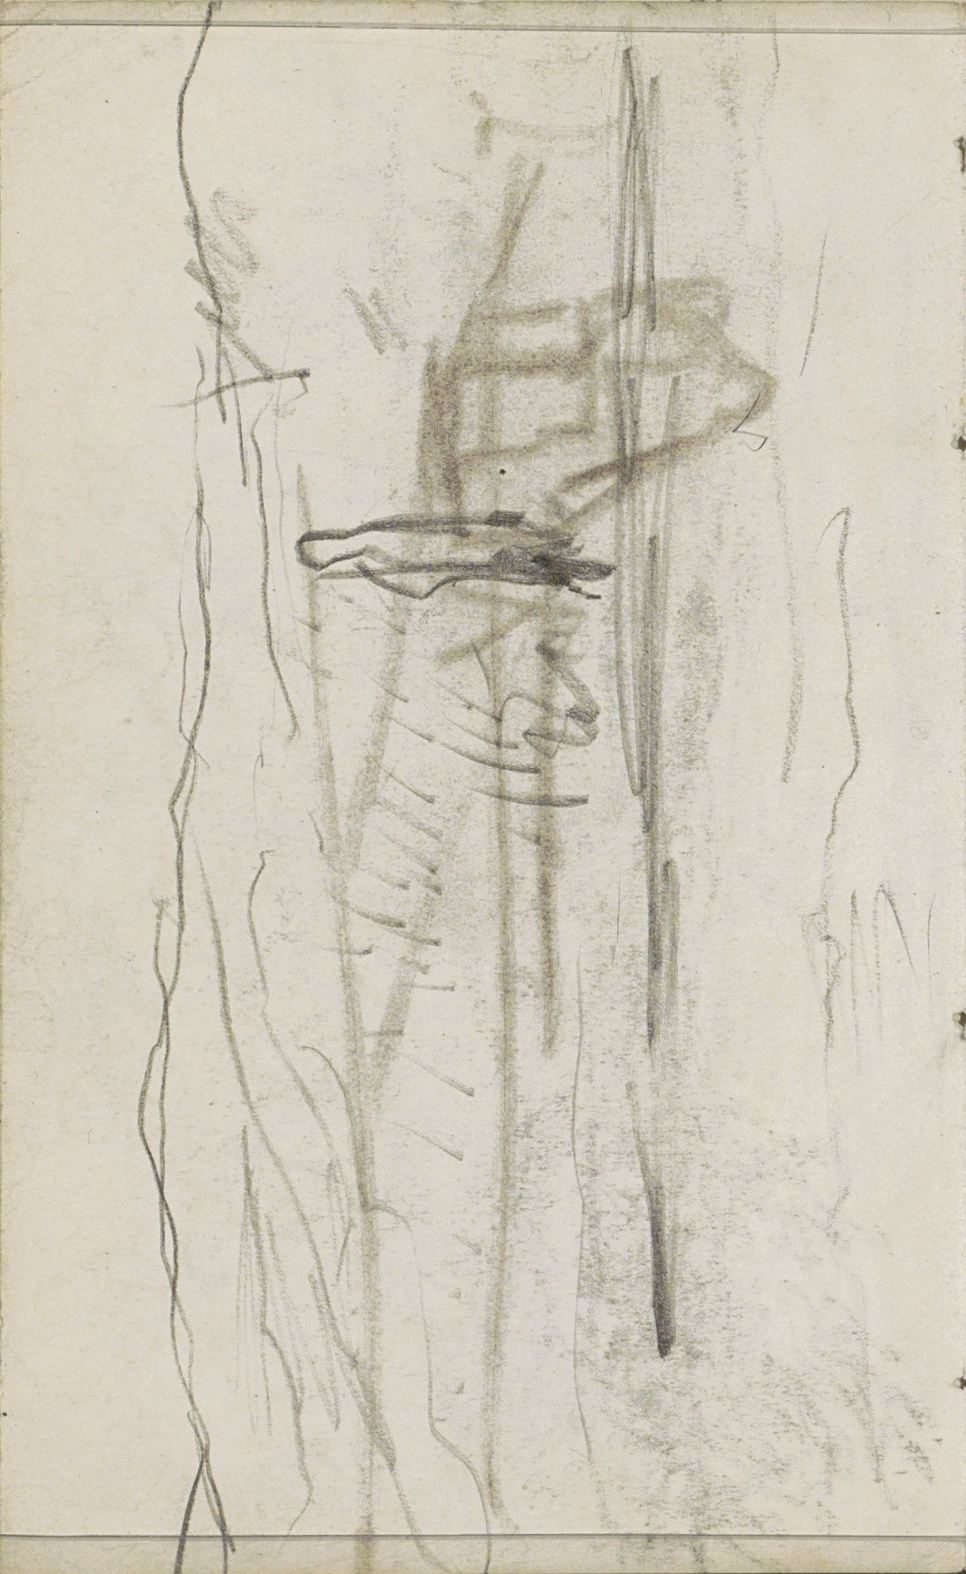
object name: sketchbook leaf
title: Landschap met een figuur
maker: anton mauve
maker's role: draughtsman, painter, print maker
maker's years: 1838-1888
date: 1848-1888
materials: chalk, paper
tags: landscapes (+ landscape with figures, staffage)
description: Blad 41 verso uit een schetsboek met 53 bladen.